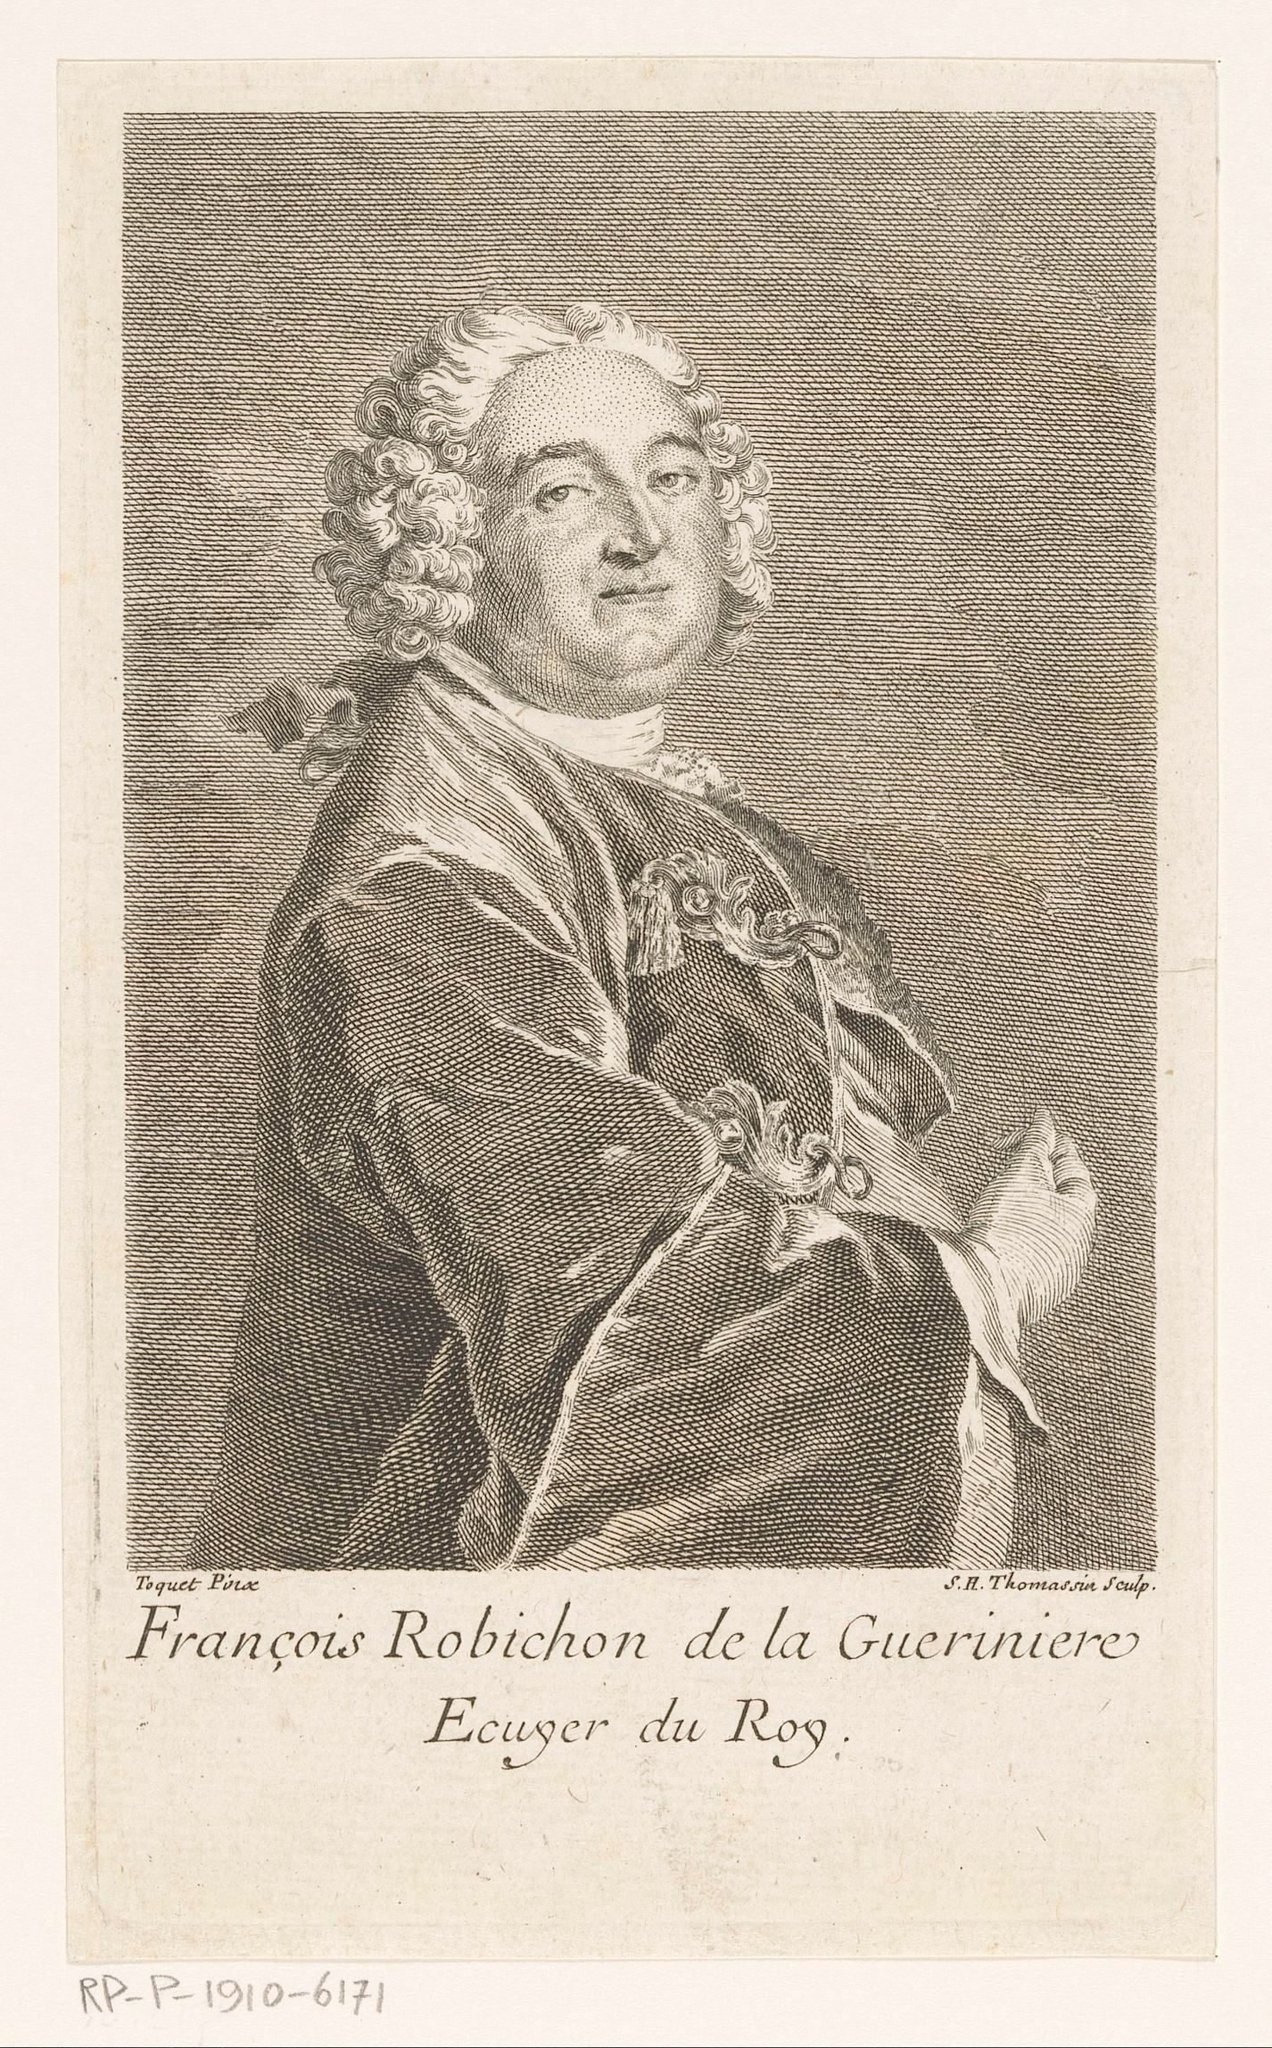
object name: print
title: Portret van François Robichon de la Guérinière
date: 1697-1741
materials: paper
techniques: engraving, etching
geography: france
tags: paris, historical persons, training of horses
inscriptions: collector's mark: Lugt 2228